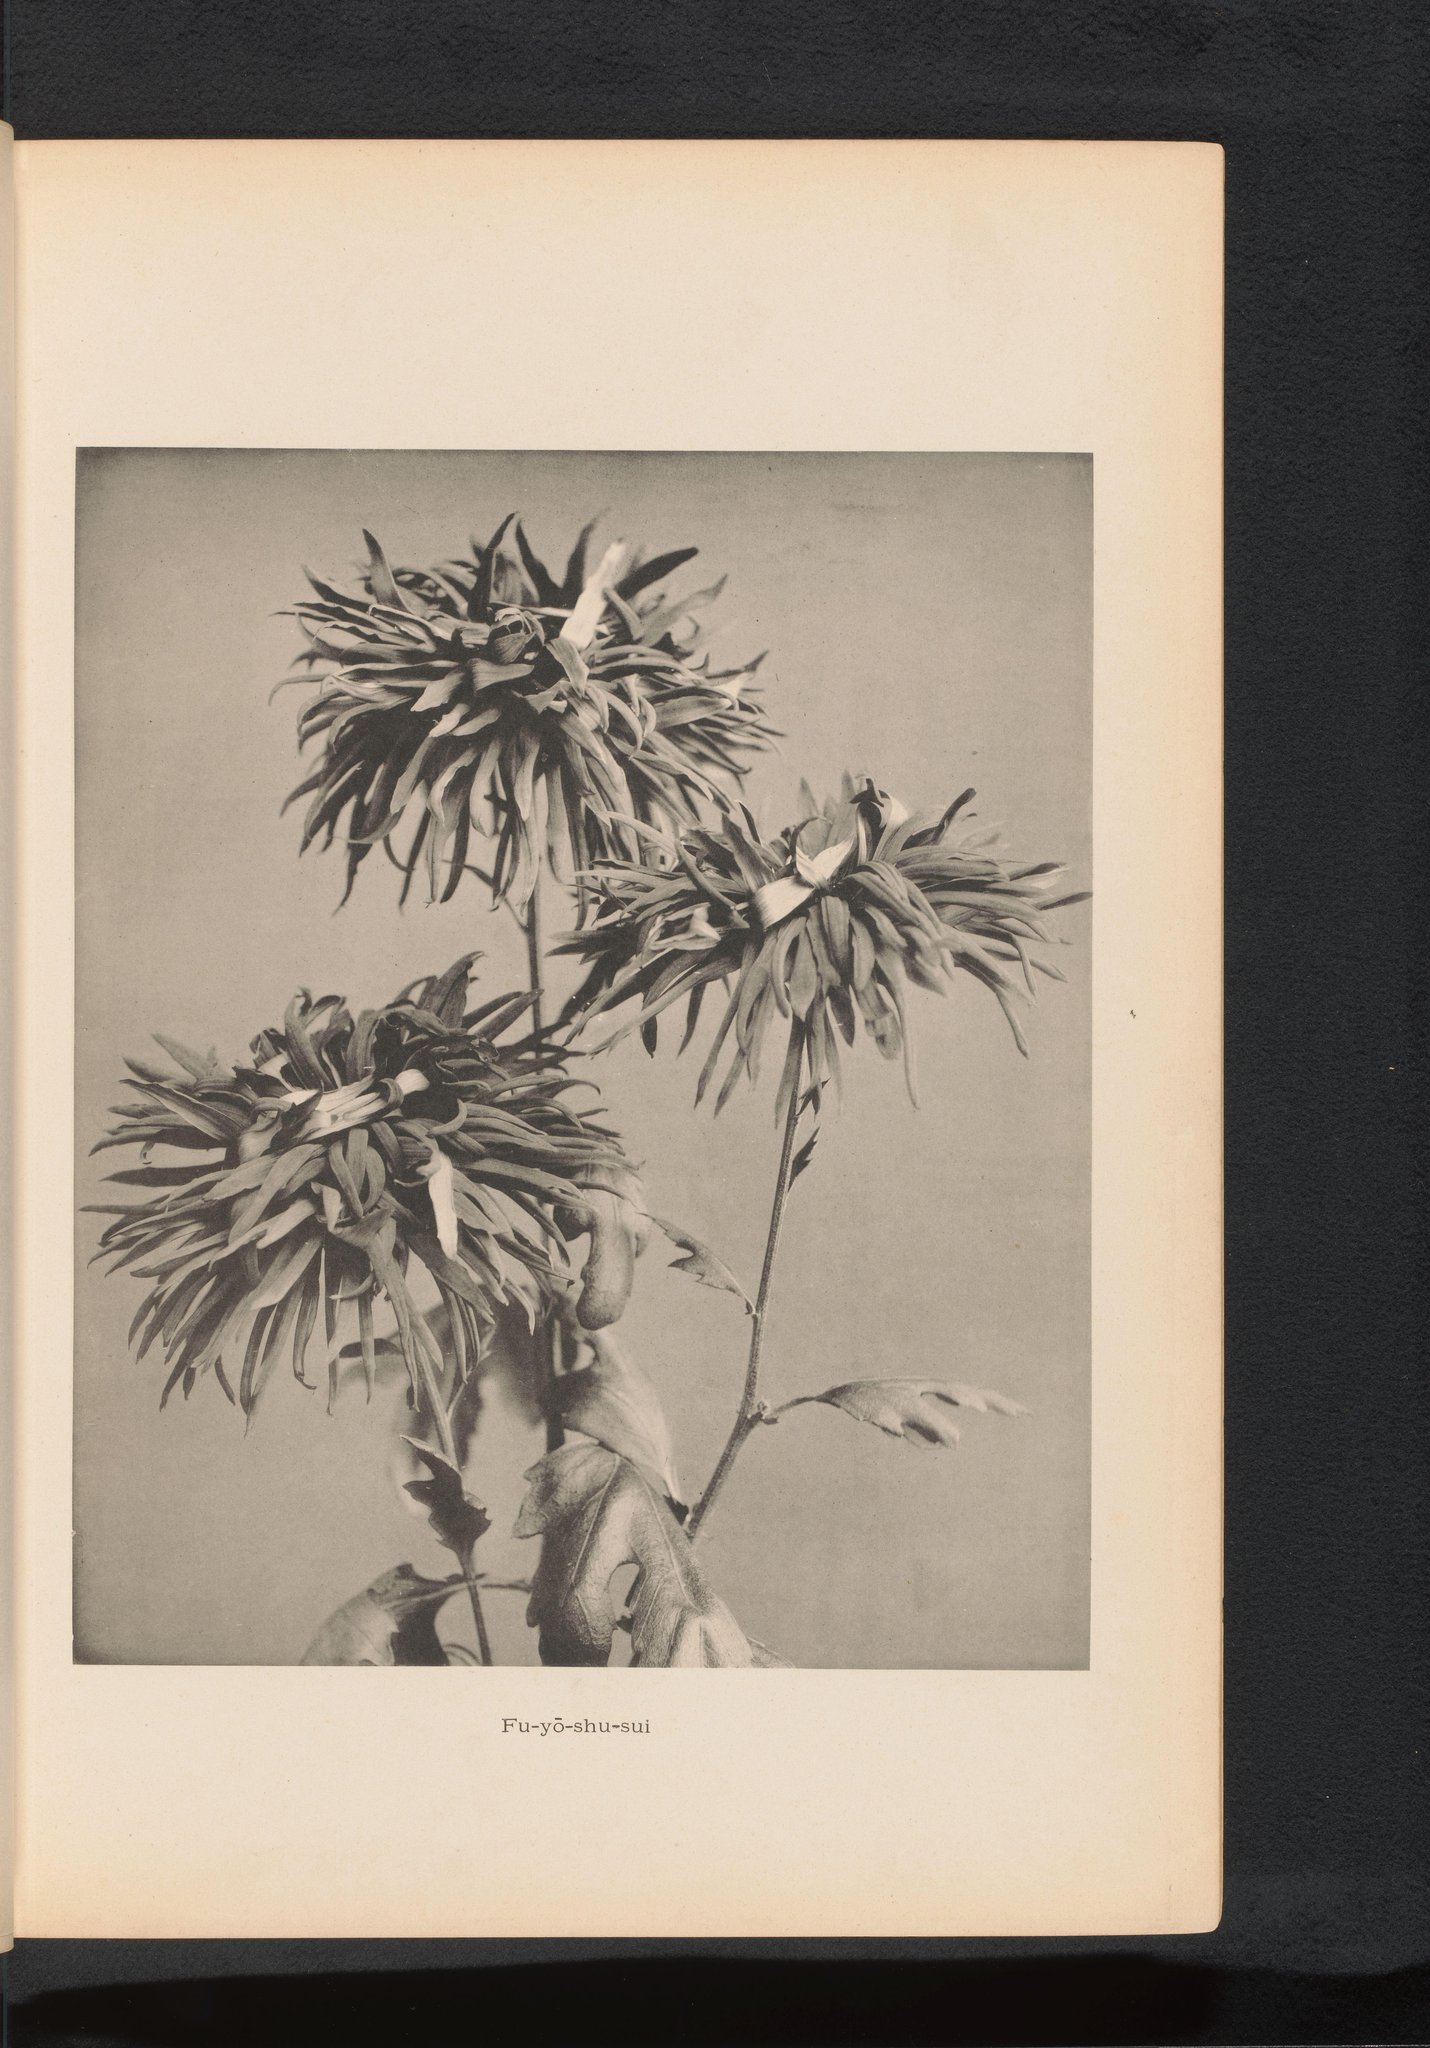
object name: page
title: Fu-yo-shu-sui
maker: kazumasa ogawa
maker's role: auteur, fotograaf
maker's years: 1860-1929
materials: paper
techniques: photograph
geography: tokyo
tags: flowers: chrysanthemum, japan